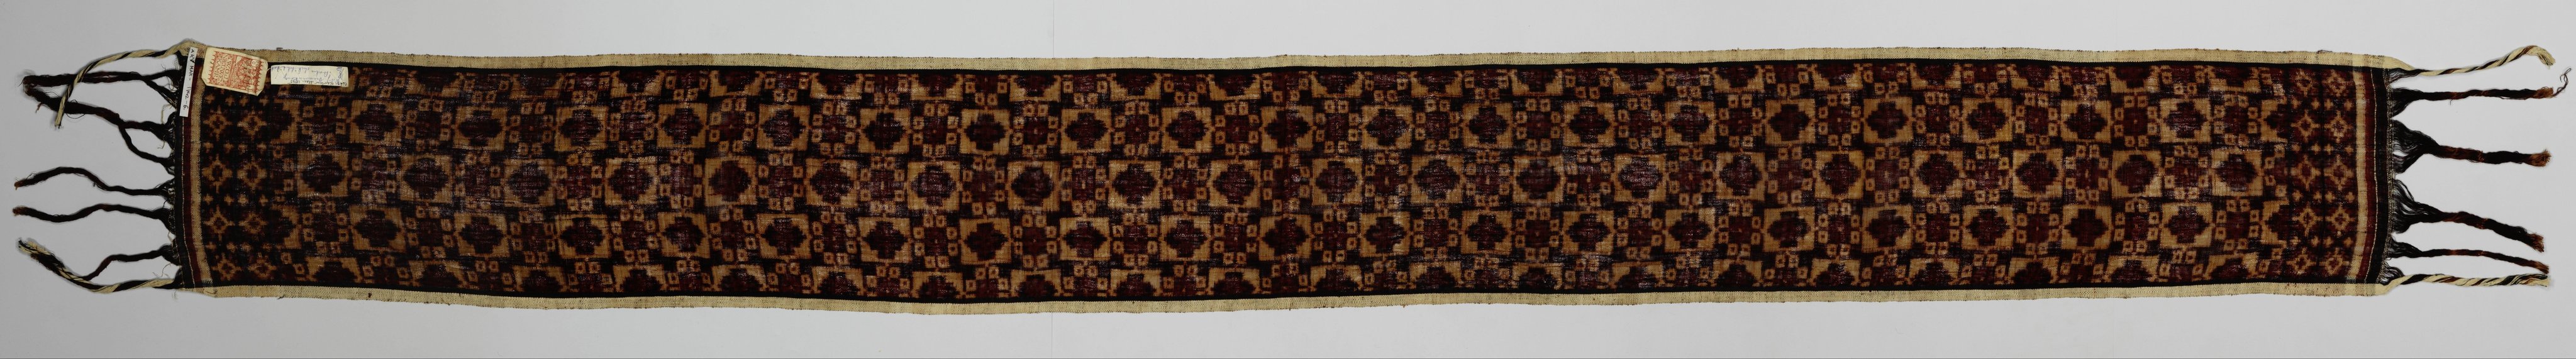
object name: cloth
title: Geringsing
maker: Anonymous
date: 1900-1920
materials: cotton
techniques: weave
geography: bali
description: Doek met geometrische motieven. In het begin van de twintigste eeuw in het bezit geweest van de kunstenaar W.O.J. Nieuwenkamp, die een van de eerste Europeanen was, die deze geringsing doeken ontdekte. Deze doek is in zijn bezit geweest en heeft nog een label met zijn naam...